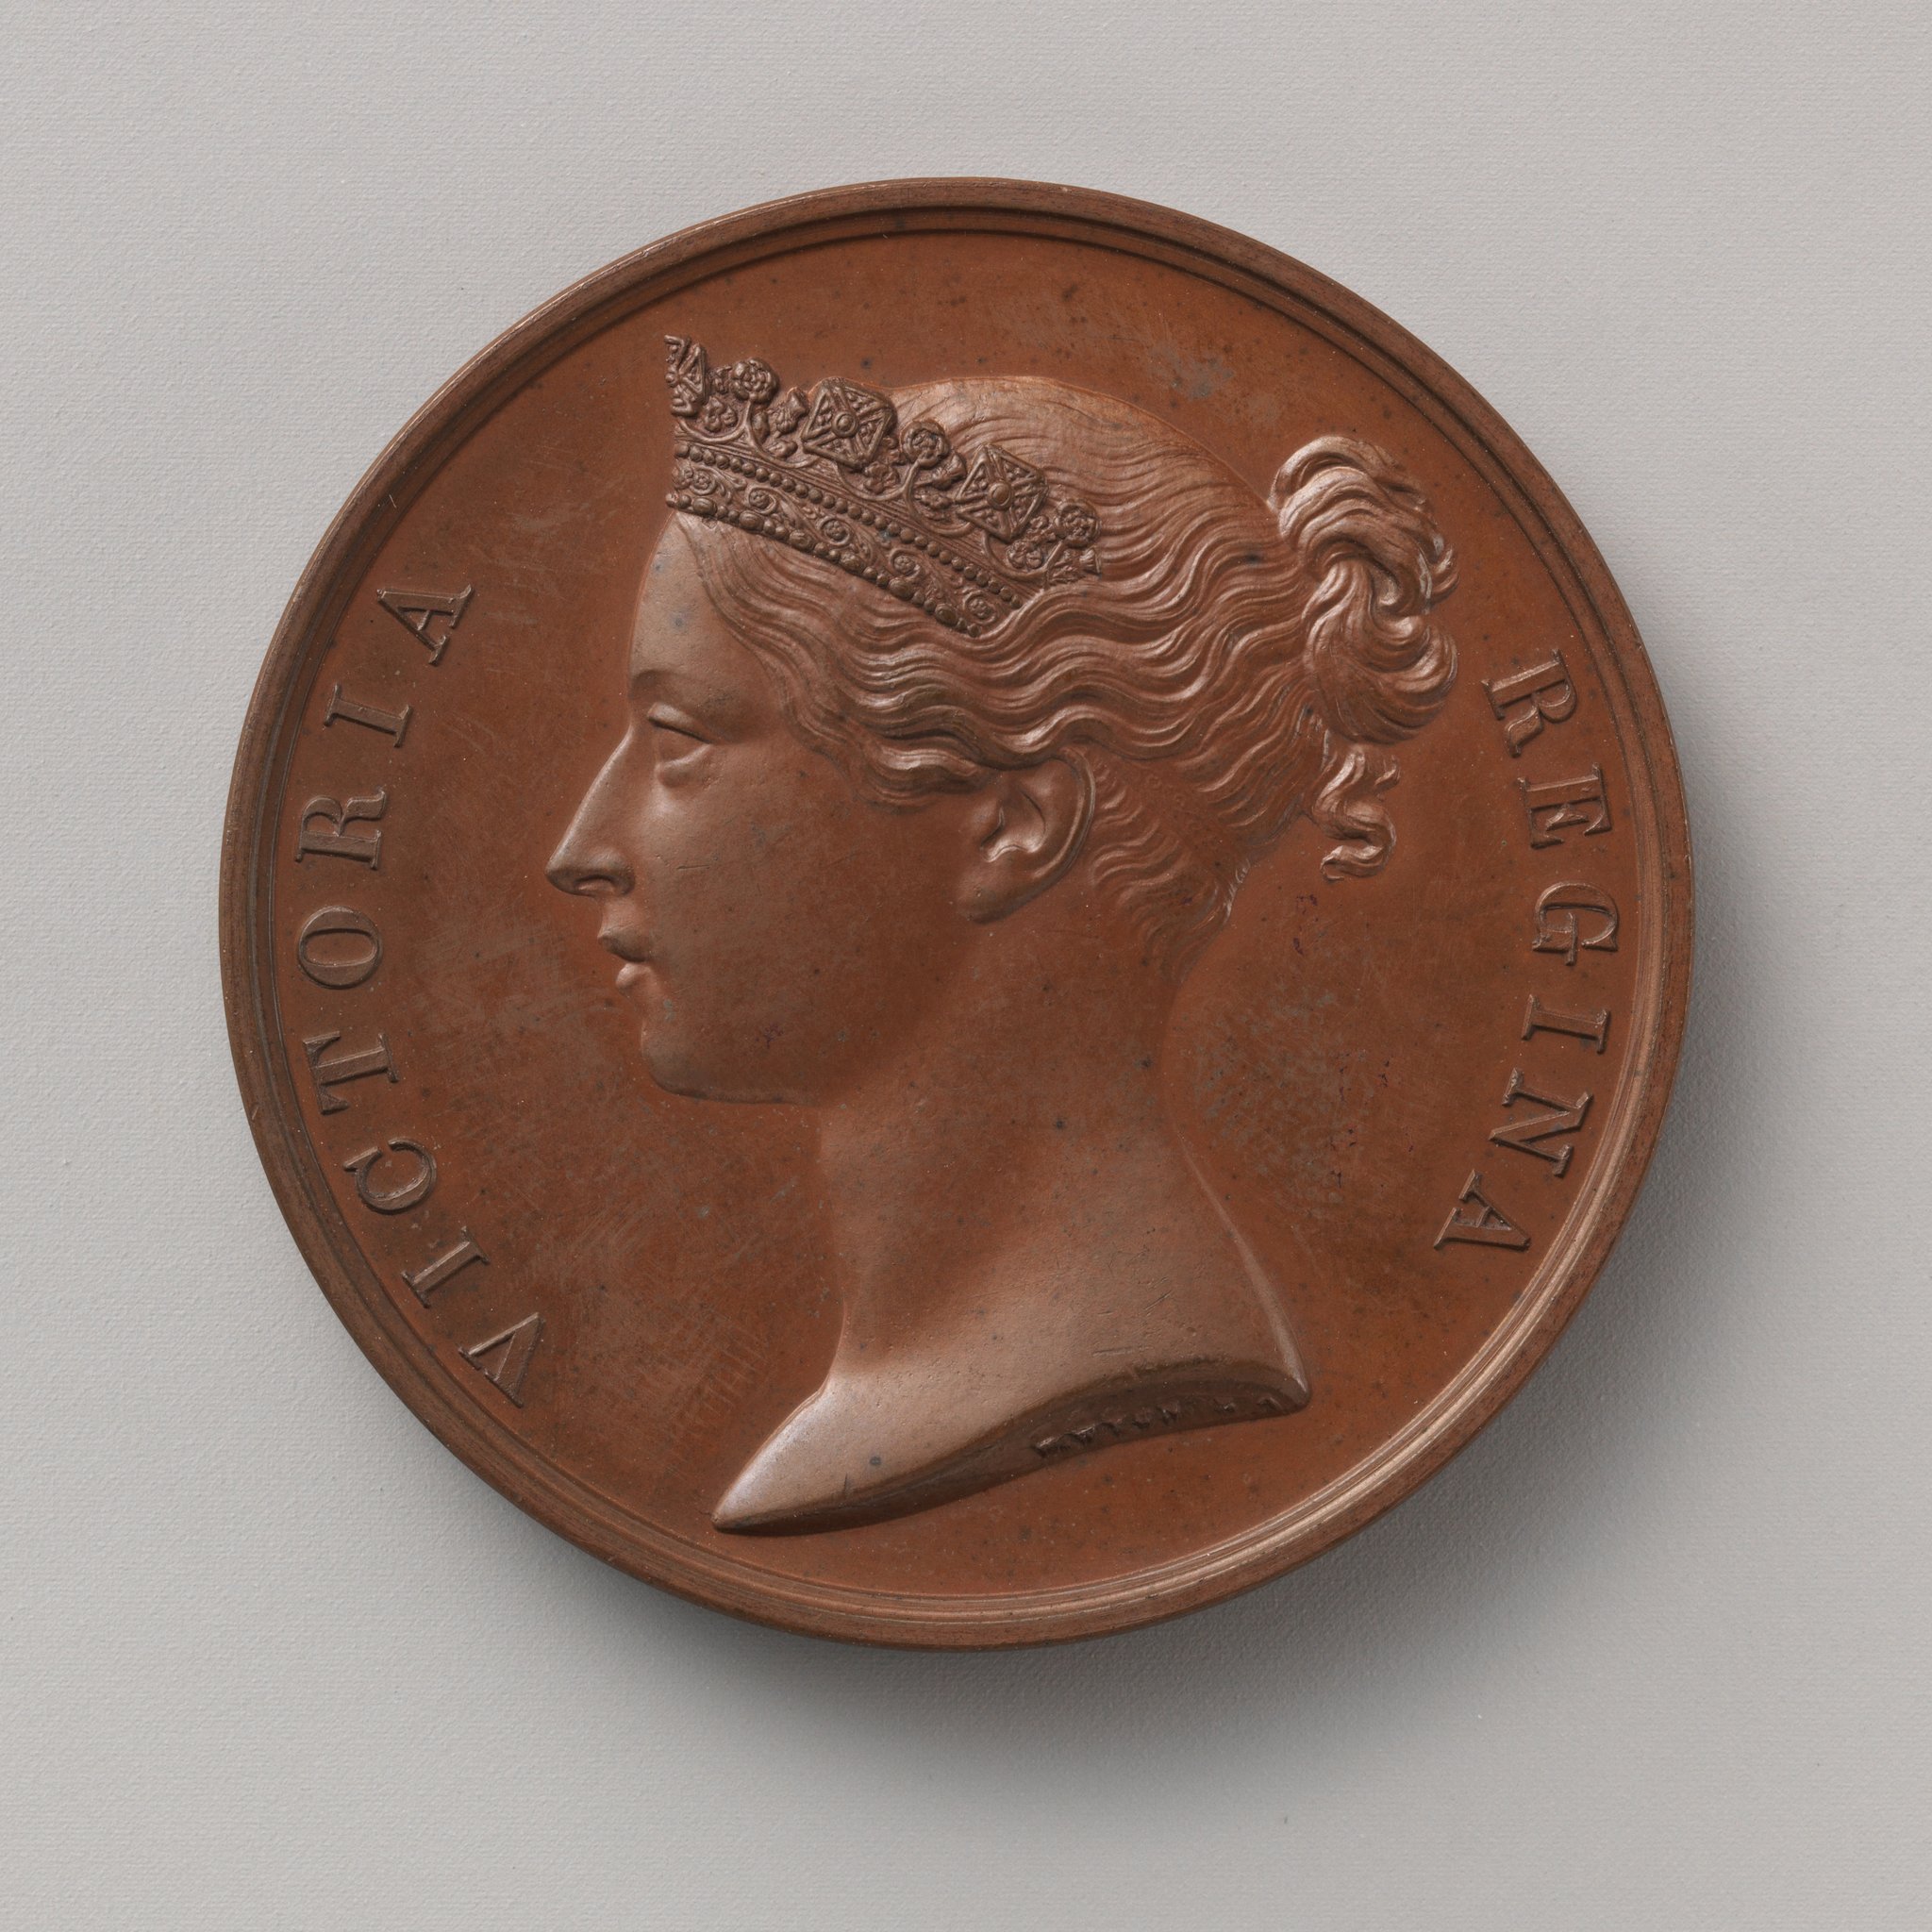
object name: medal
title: The China Medal of 1842, granted by the Government of India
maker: william wyon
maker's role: artist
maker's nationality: british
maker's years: 1795-1851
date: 1842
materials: bronze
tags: shields,cannons,profiles,women